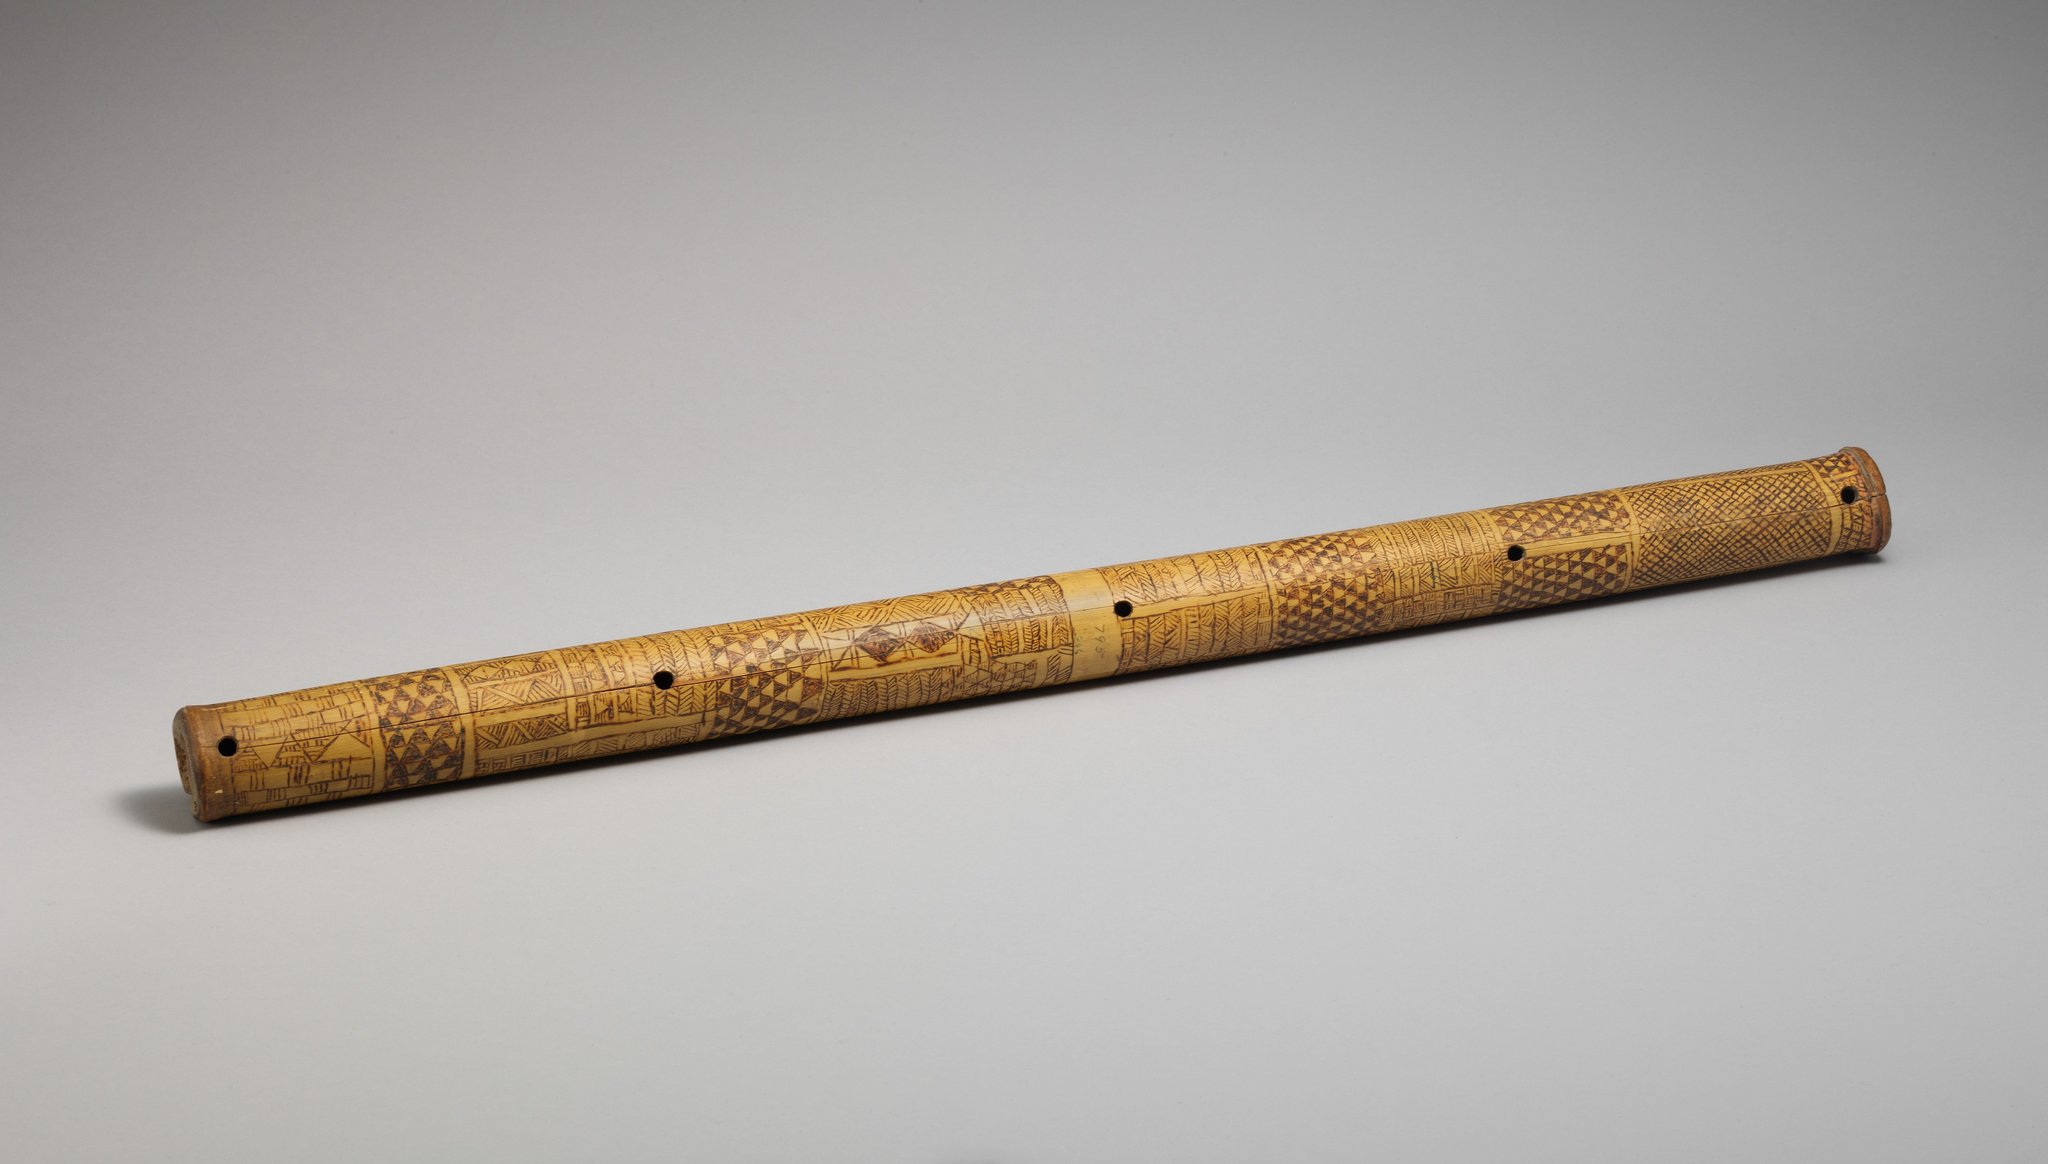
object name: mbita ni tanga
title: Mbita-Ni-Tanga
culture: melanesian, fijian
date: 1830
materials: bamboo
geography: fiji